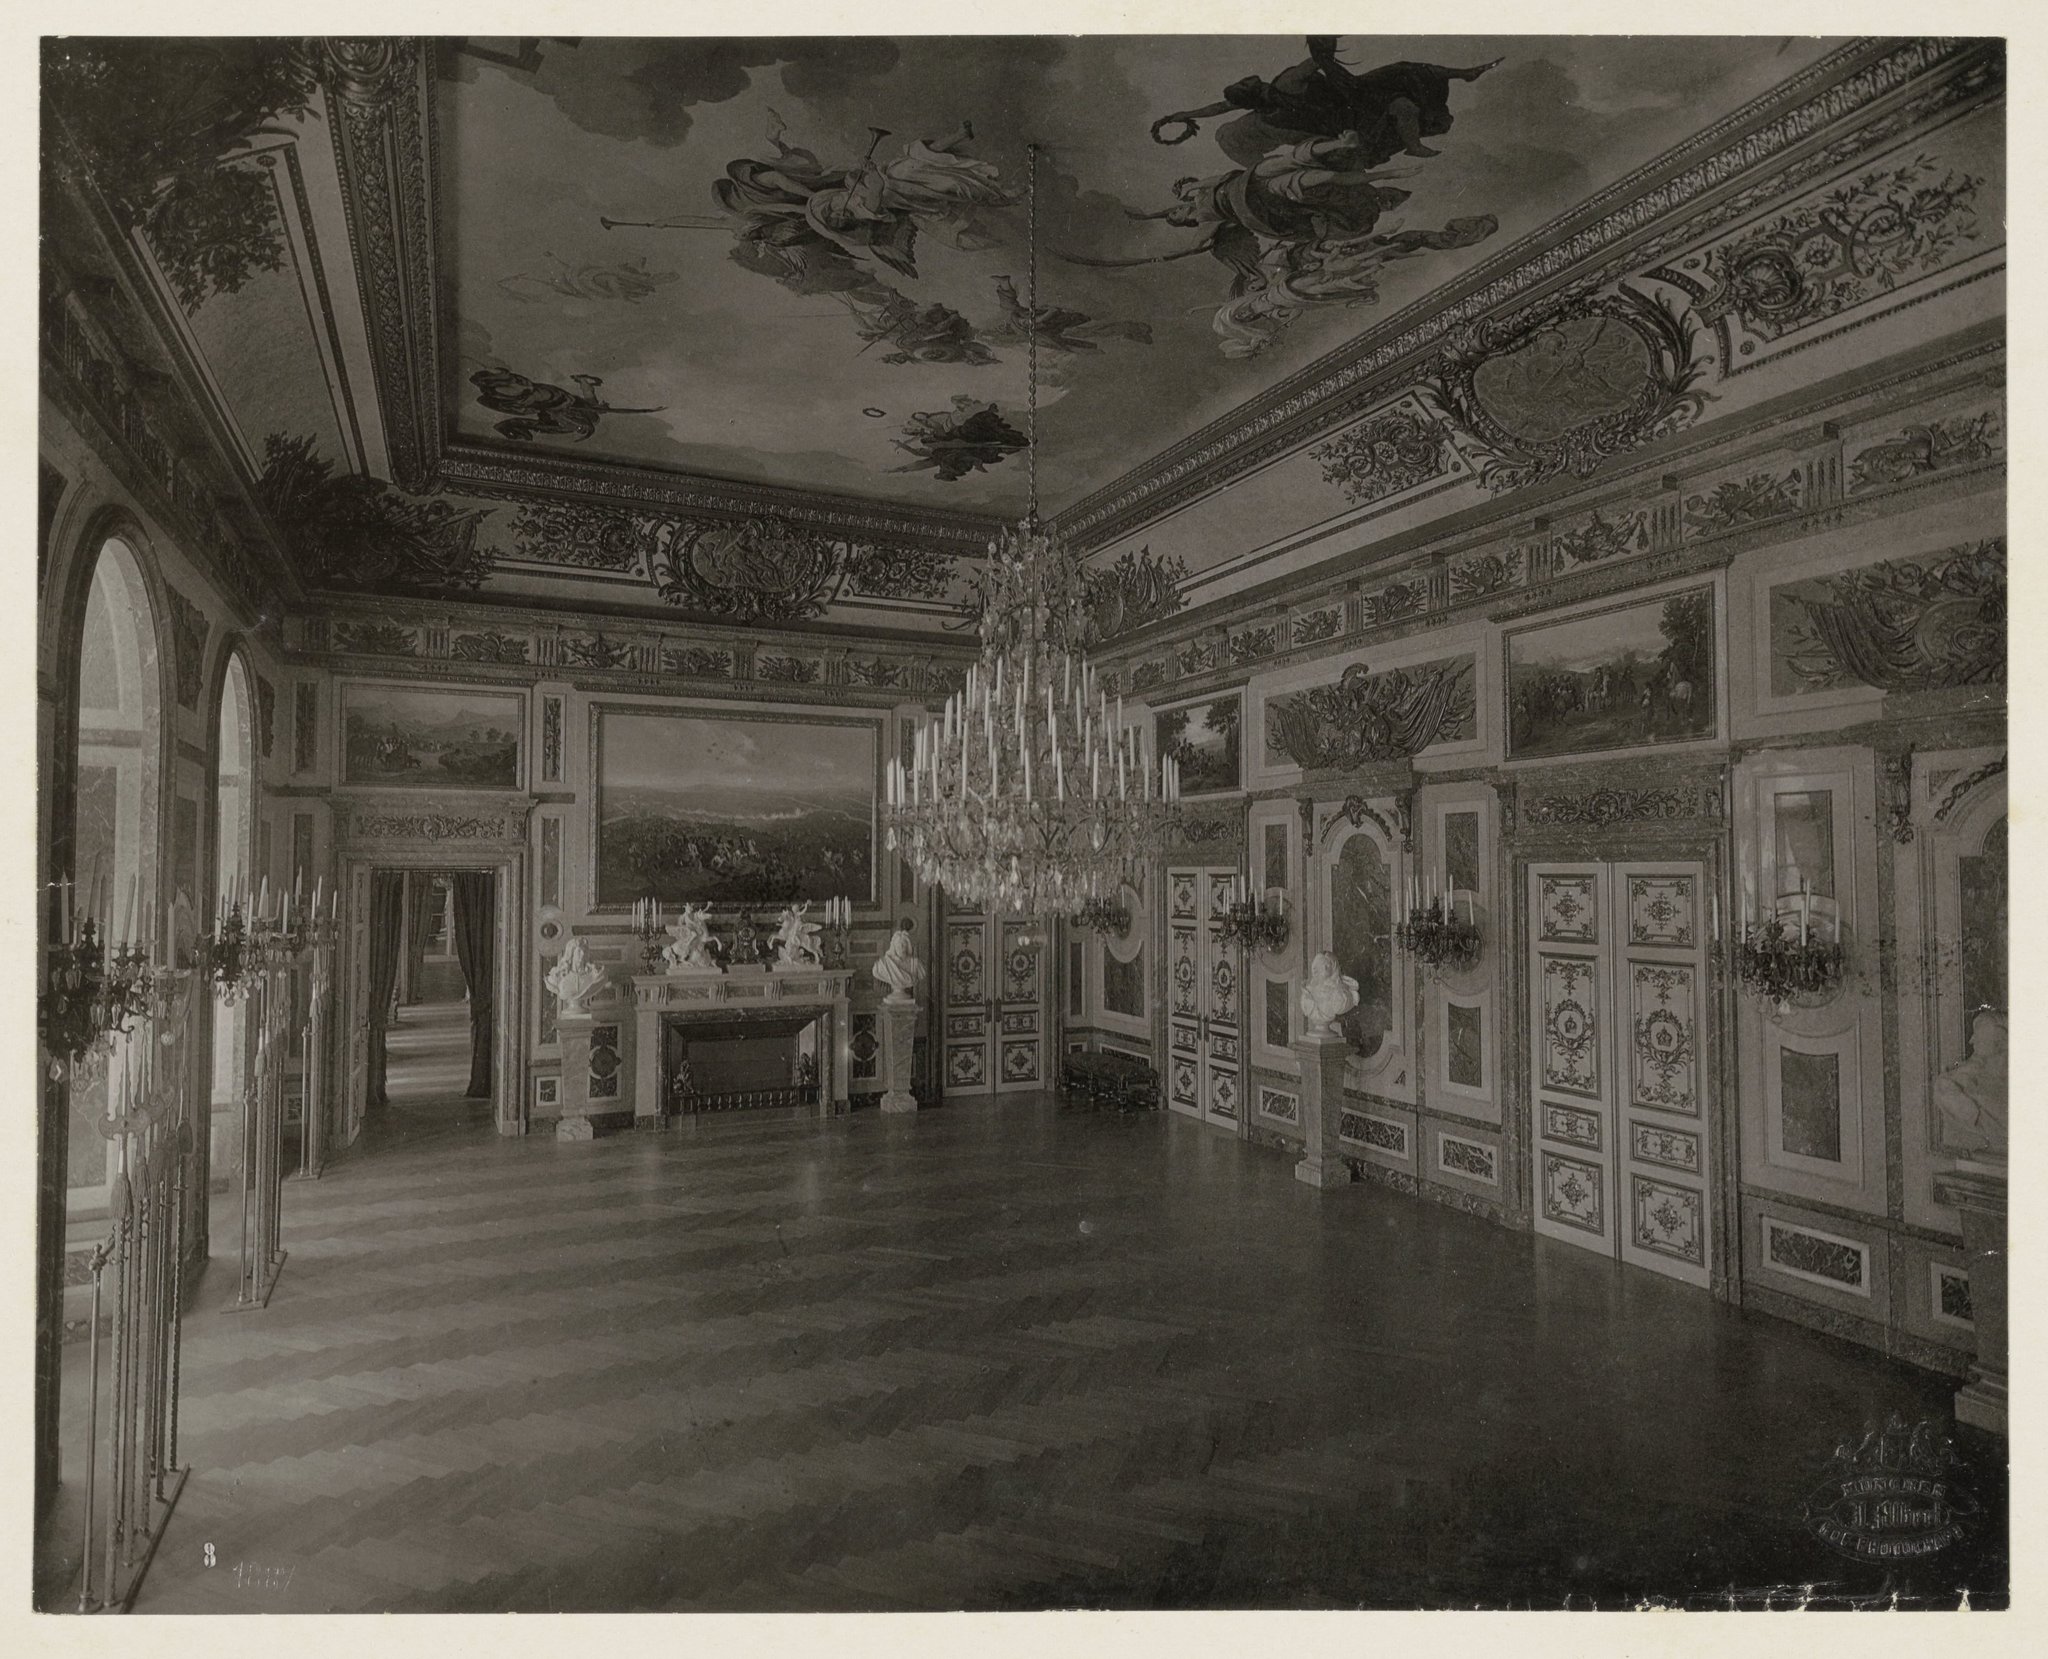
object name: photomechanical print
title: Hartschiersaal in slot Herrenchiemsee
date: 1887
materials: cardboard, paper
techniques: photograph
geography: herrenchiemsee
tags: palace - aa - civic architecture: inside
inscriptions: date: ‘1887’, number: ‘8’, check stamp: ‘München/ J. Albert/ Hof-Photograph’, inscription: ‘München’